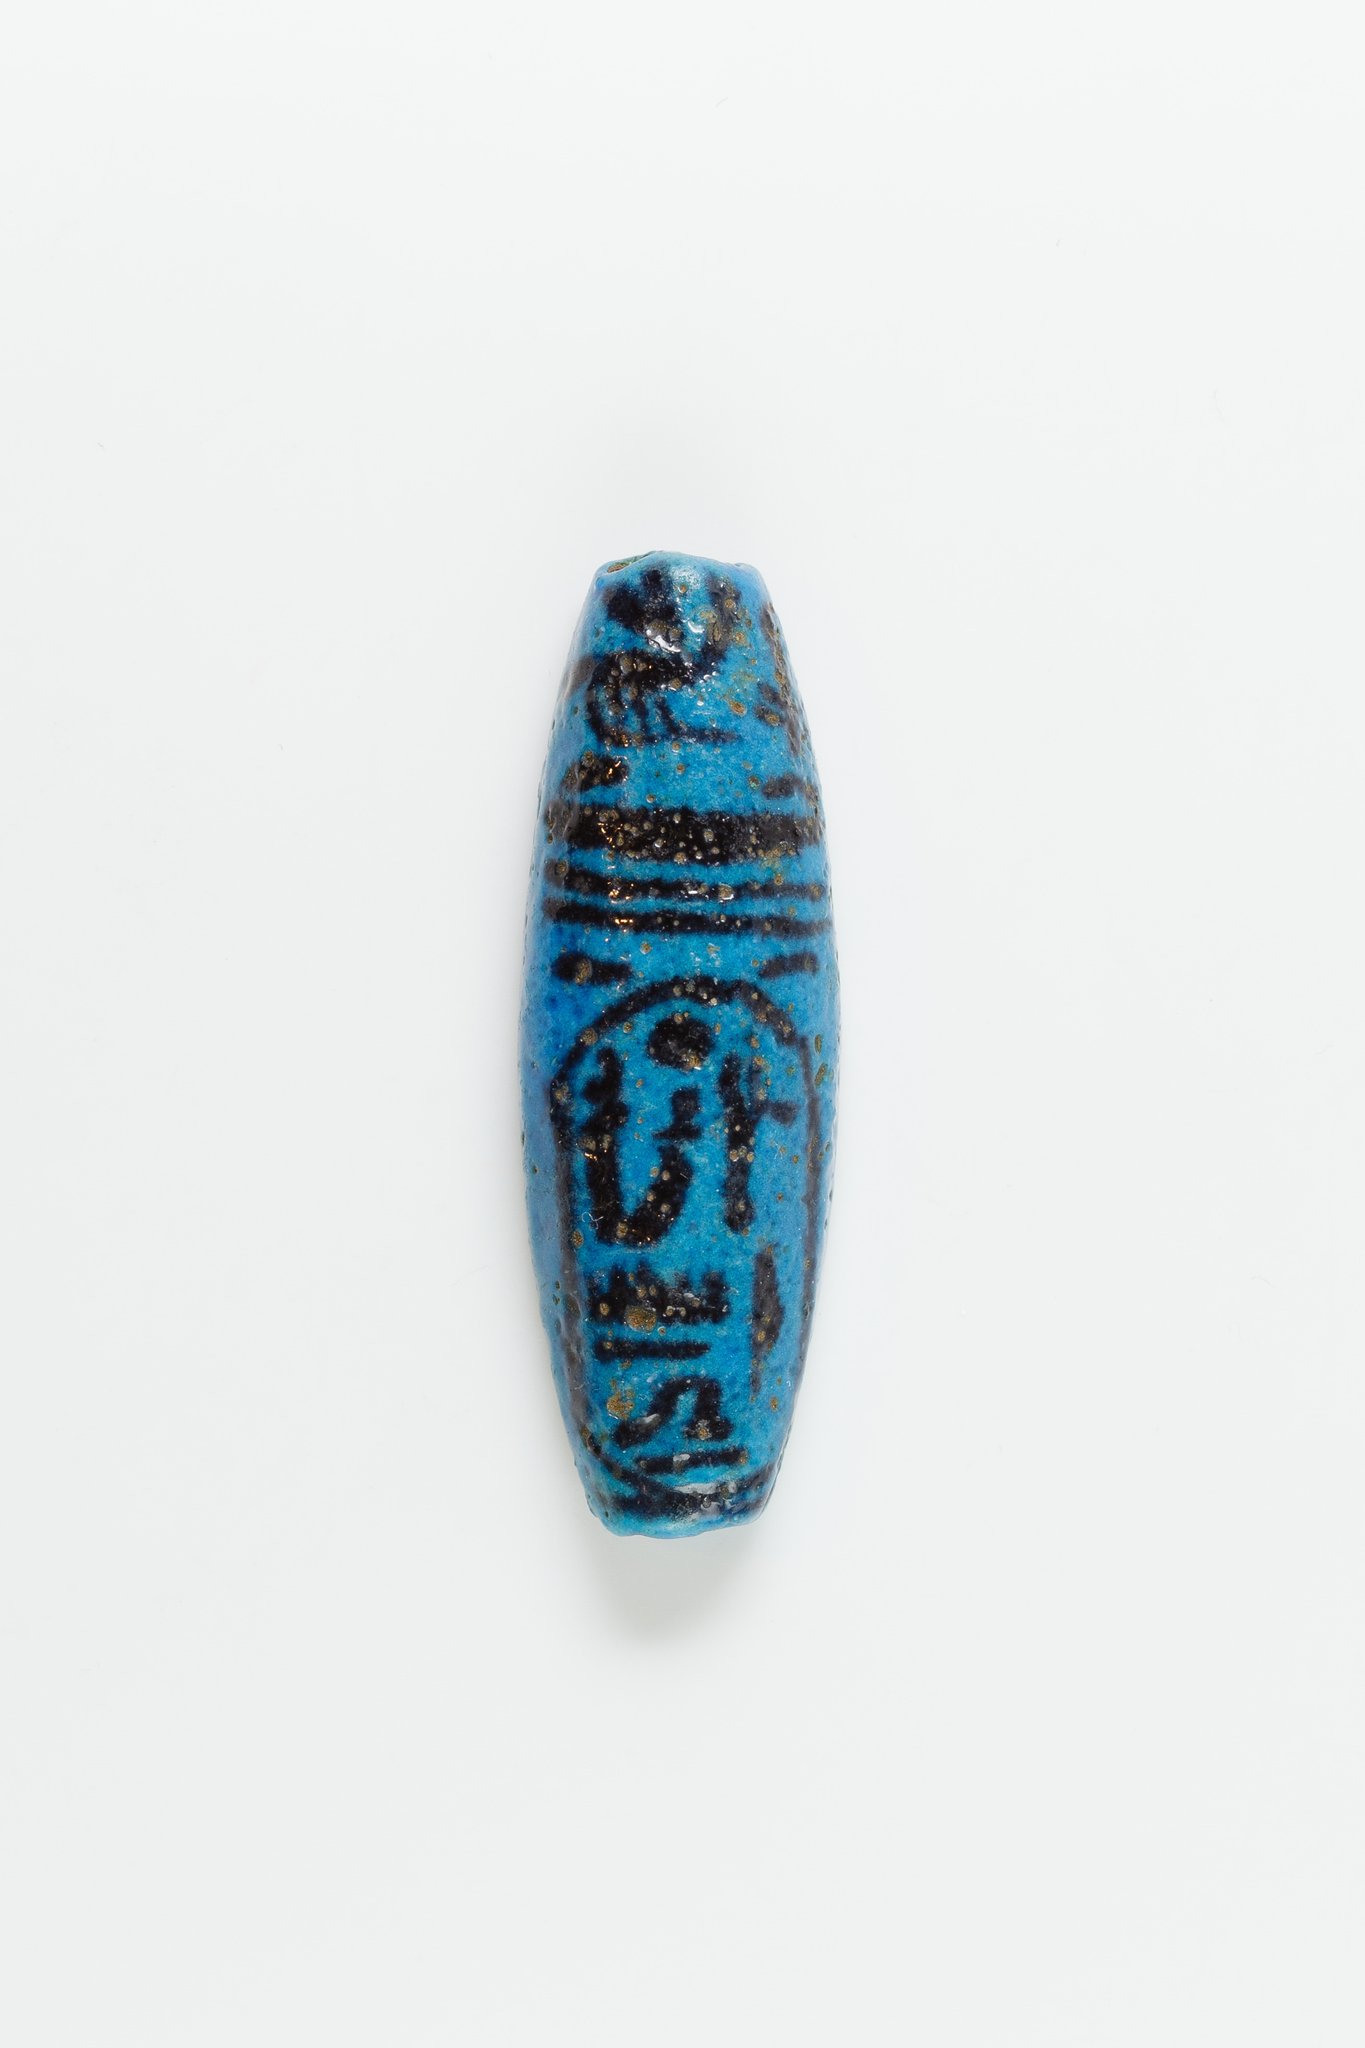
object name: bead, cartouche, royal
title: Bead with Royal Name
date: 1153-712 BCE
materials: faience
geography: egypt